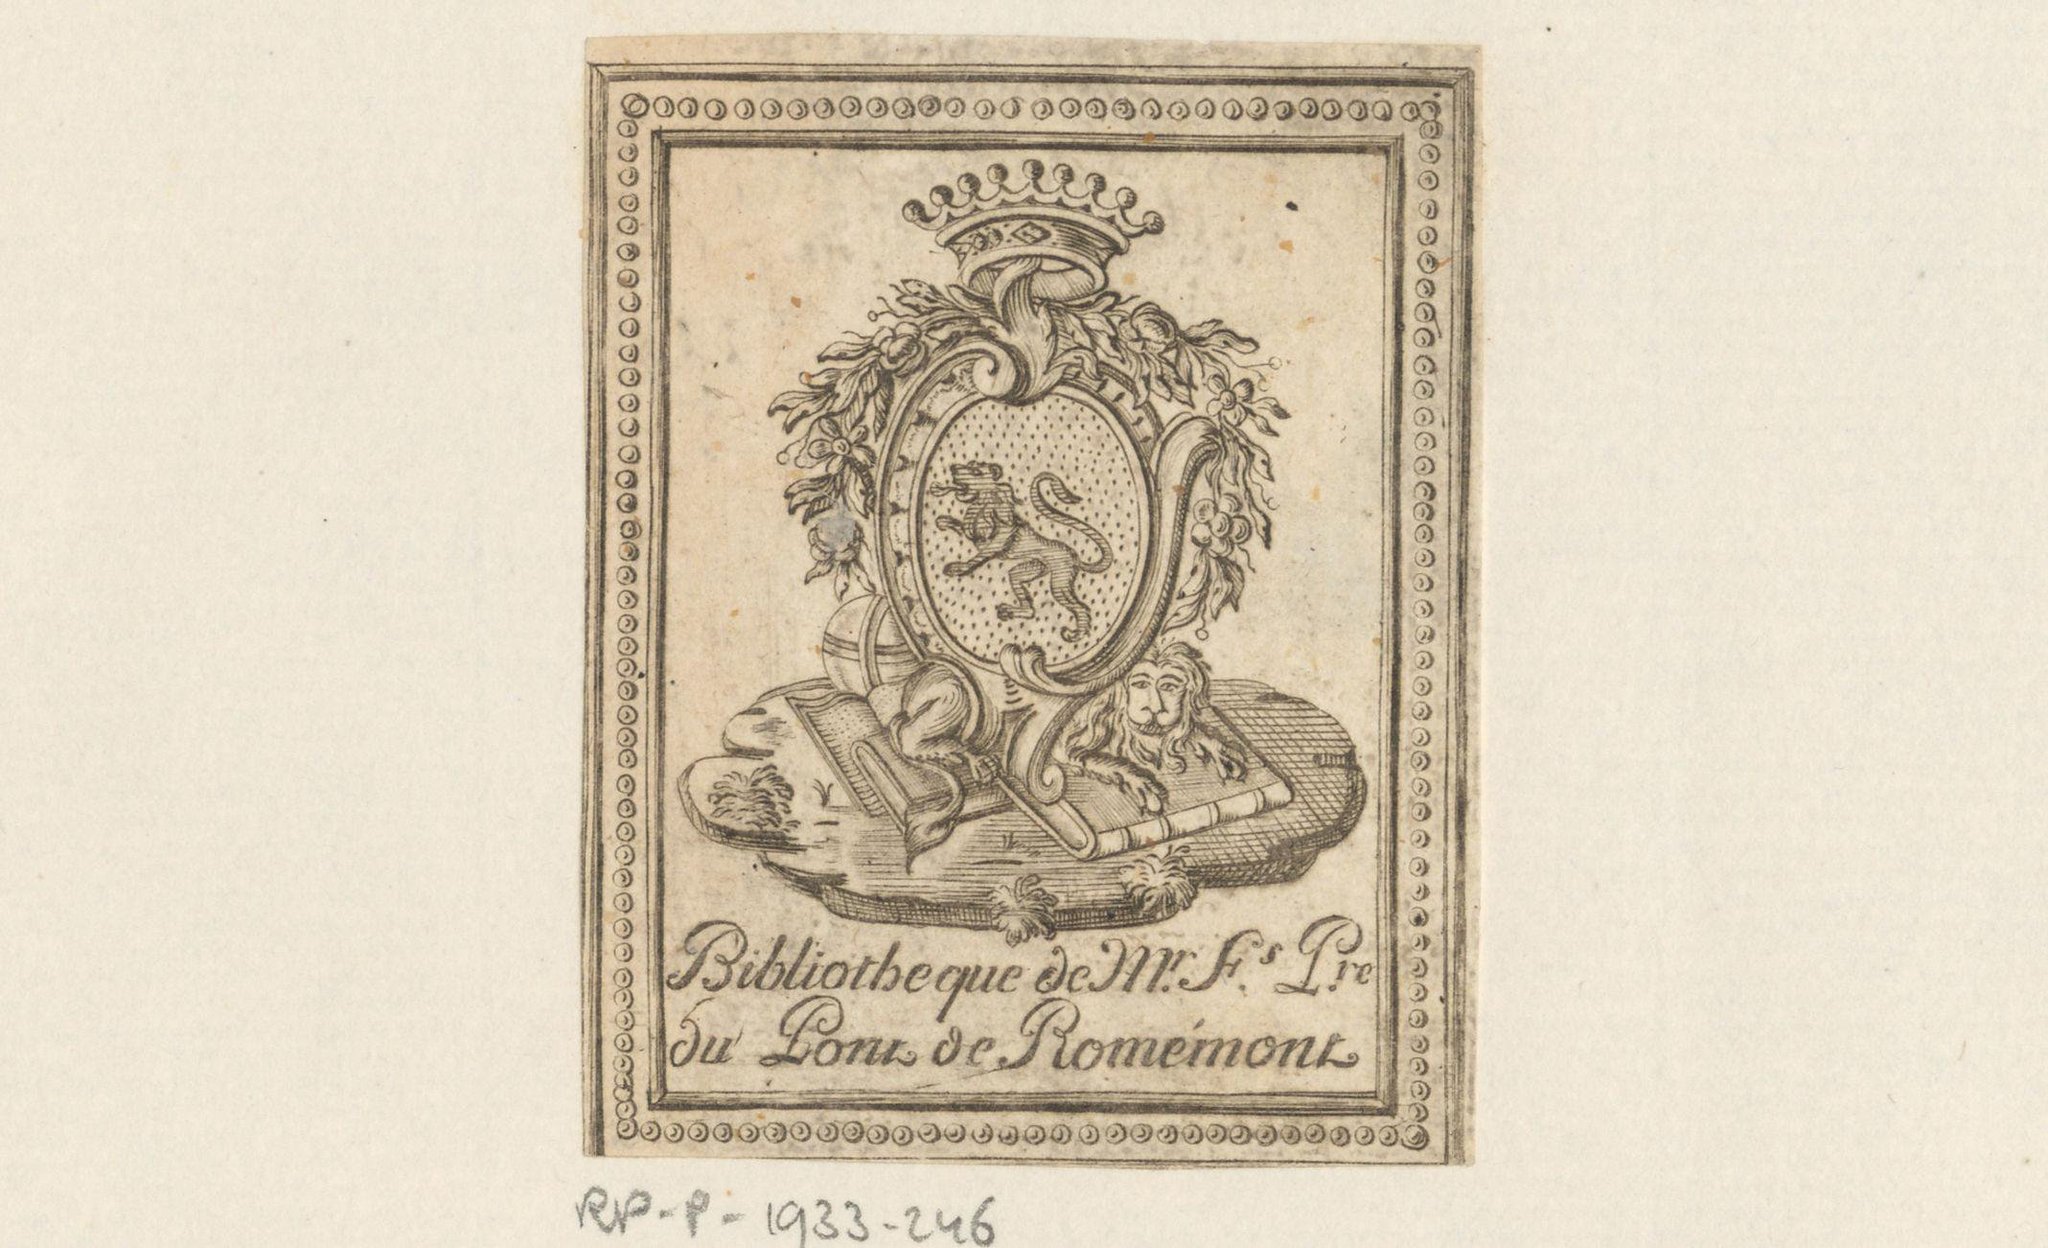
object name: bookplate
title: Ex libris van François-Pierre Dupont de Romémont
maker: Anonymous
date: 1700-1789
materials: paper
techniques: engraving, etching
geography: france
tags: beasts of prey, predatory animals: lion, armorial bearing, heraldry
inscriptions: collector's mark: Lugt 2760, collector's mark: Lugt 2233